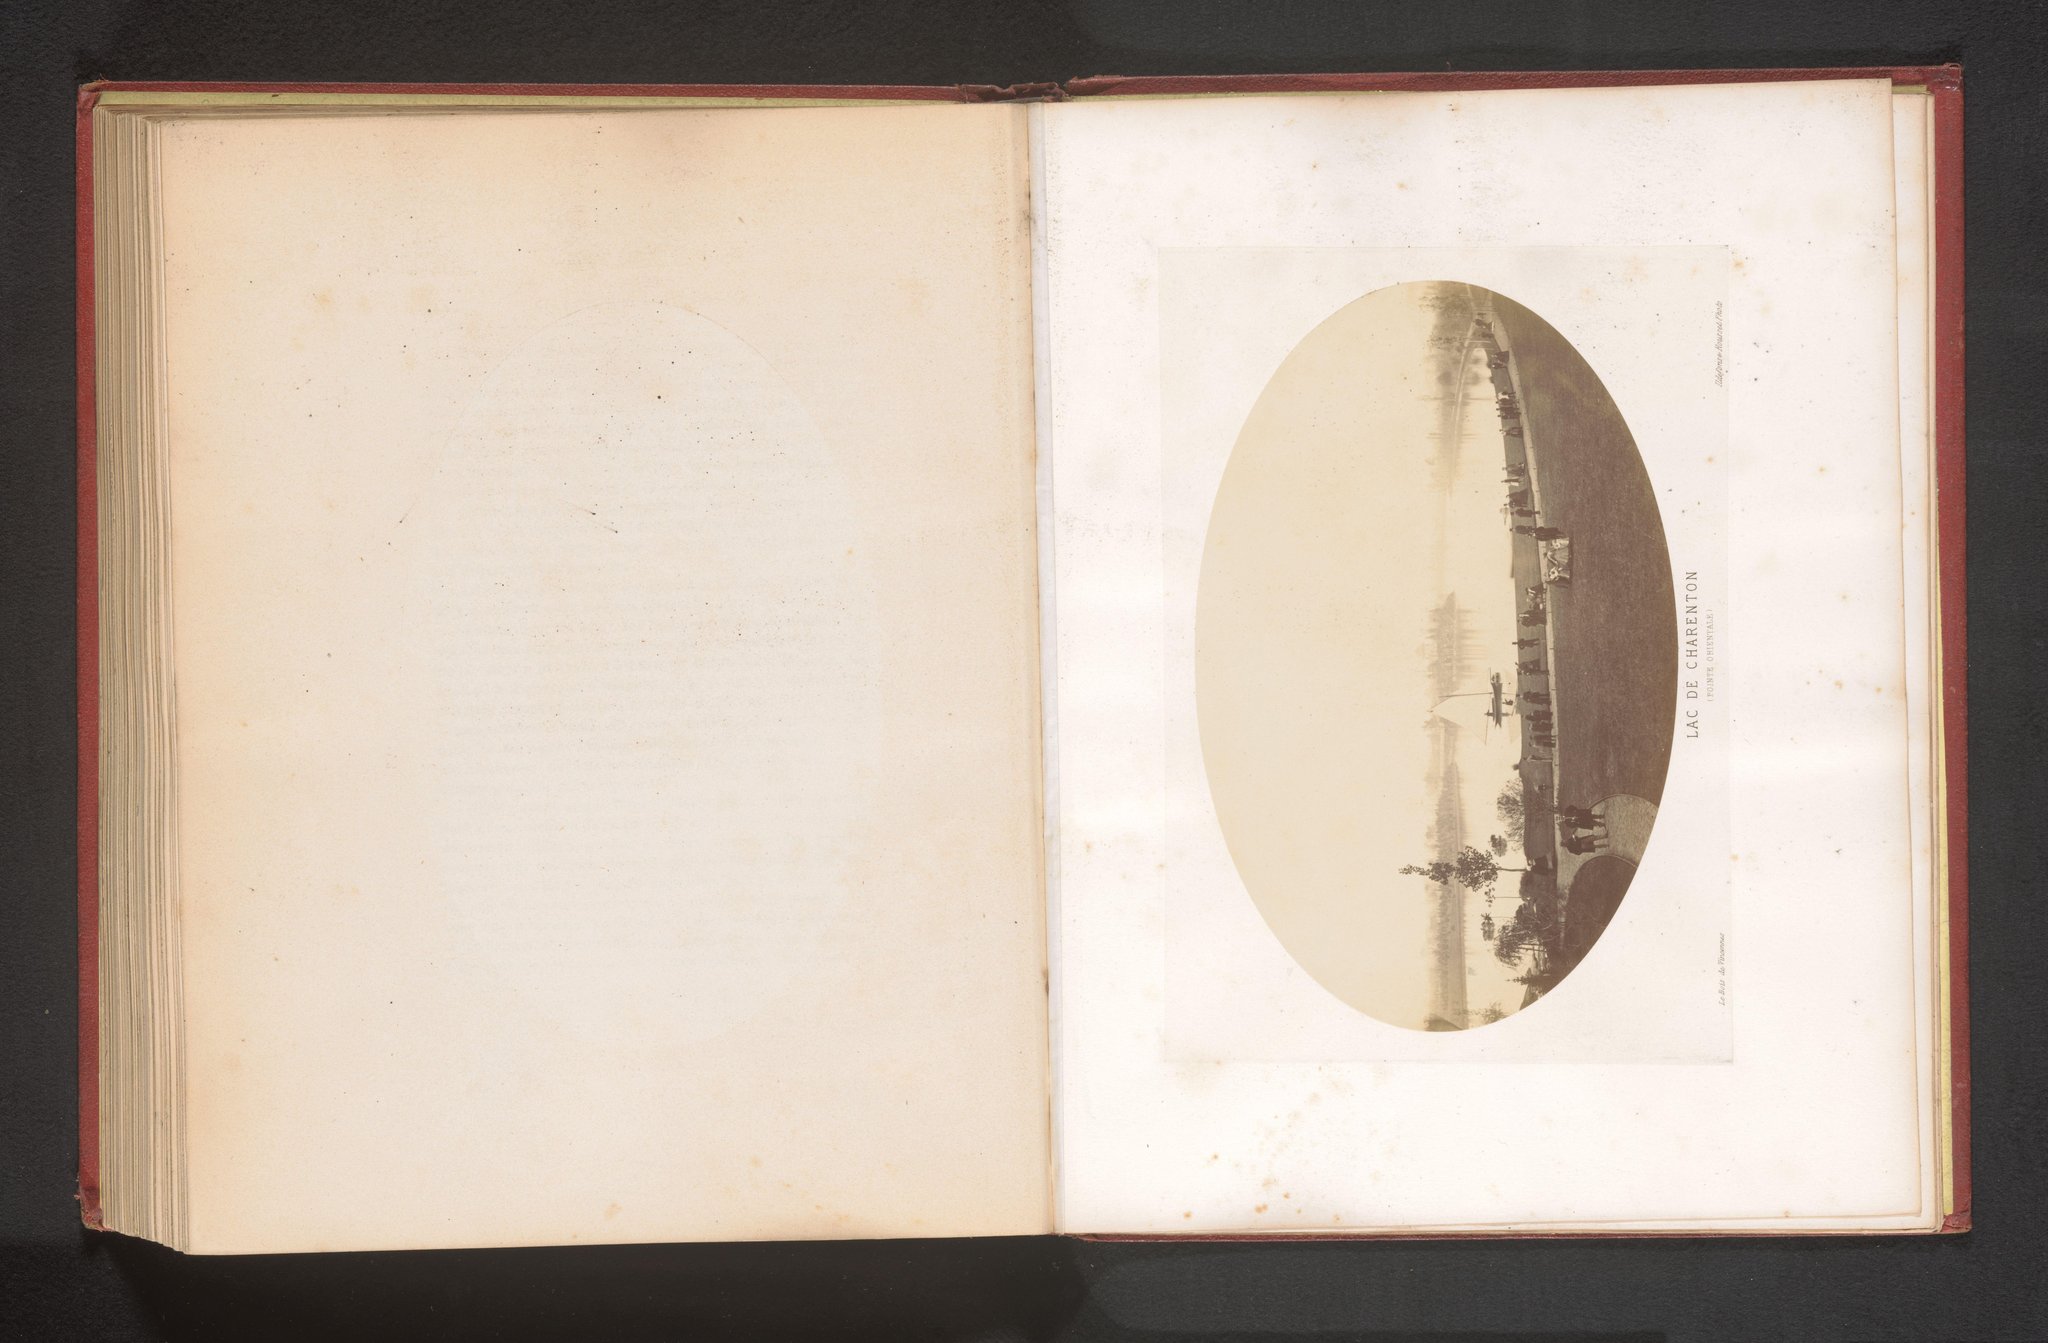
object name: photograph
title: Bois de Vincennes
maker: ildefonse rousset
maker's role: fotograaf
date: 1861-1866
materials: photographic support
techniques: albumen print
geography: bois de vincennes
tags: lake, public gardens, park